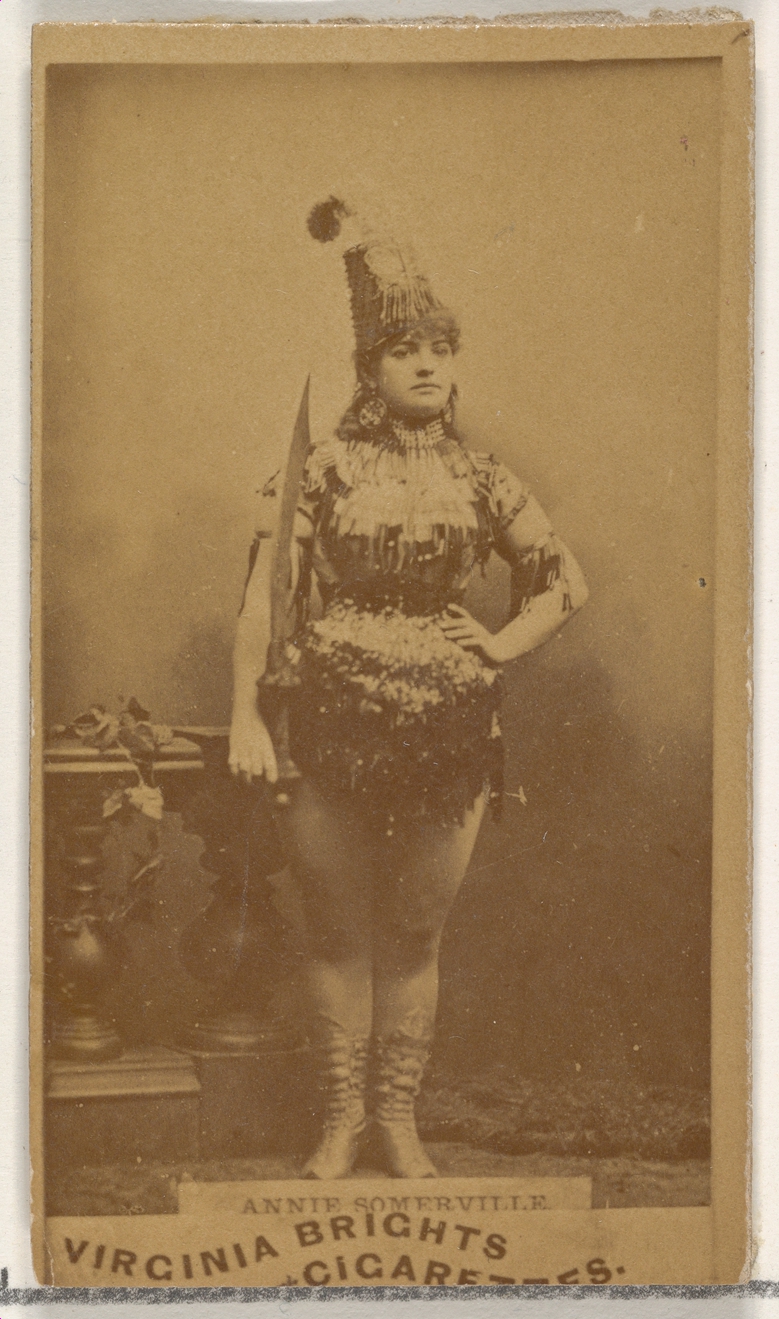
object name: photograph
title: Annie Somerville, from the Actors and Actresses series (N45, Type 1) for Virginia Brights Cigarettes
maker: allen & ginter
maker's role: publisher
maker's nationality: american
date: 1888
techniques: albumen silver print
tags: portraits,women,actresses